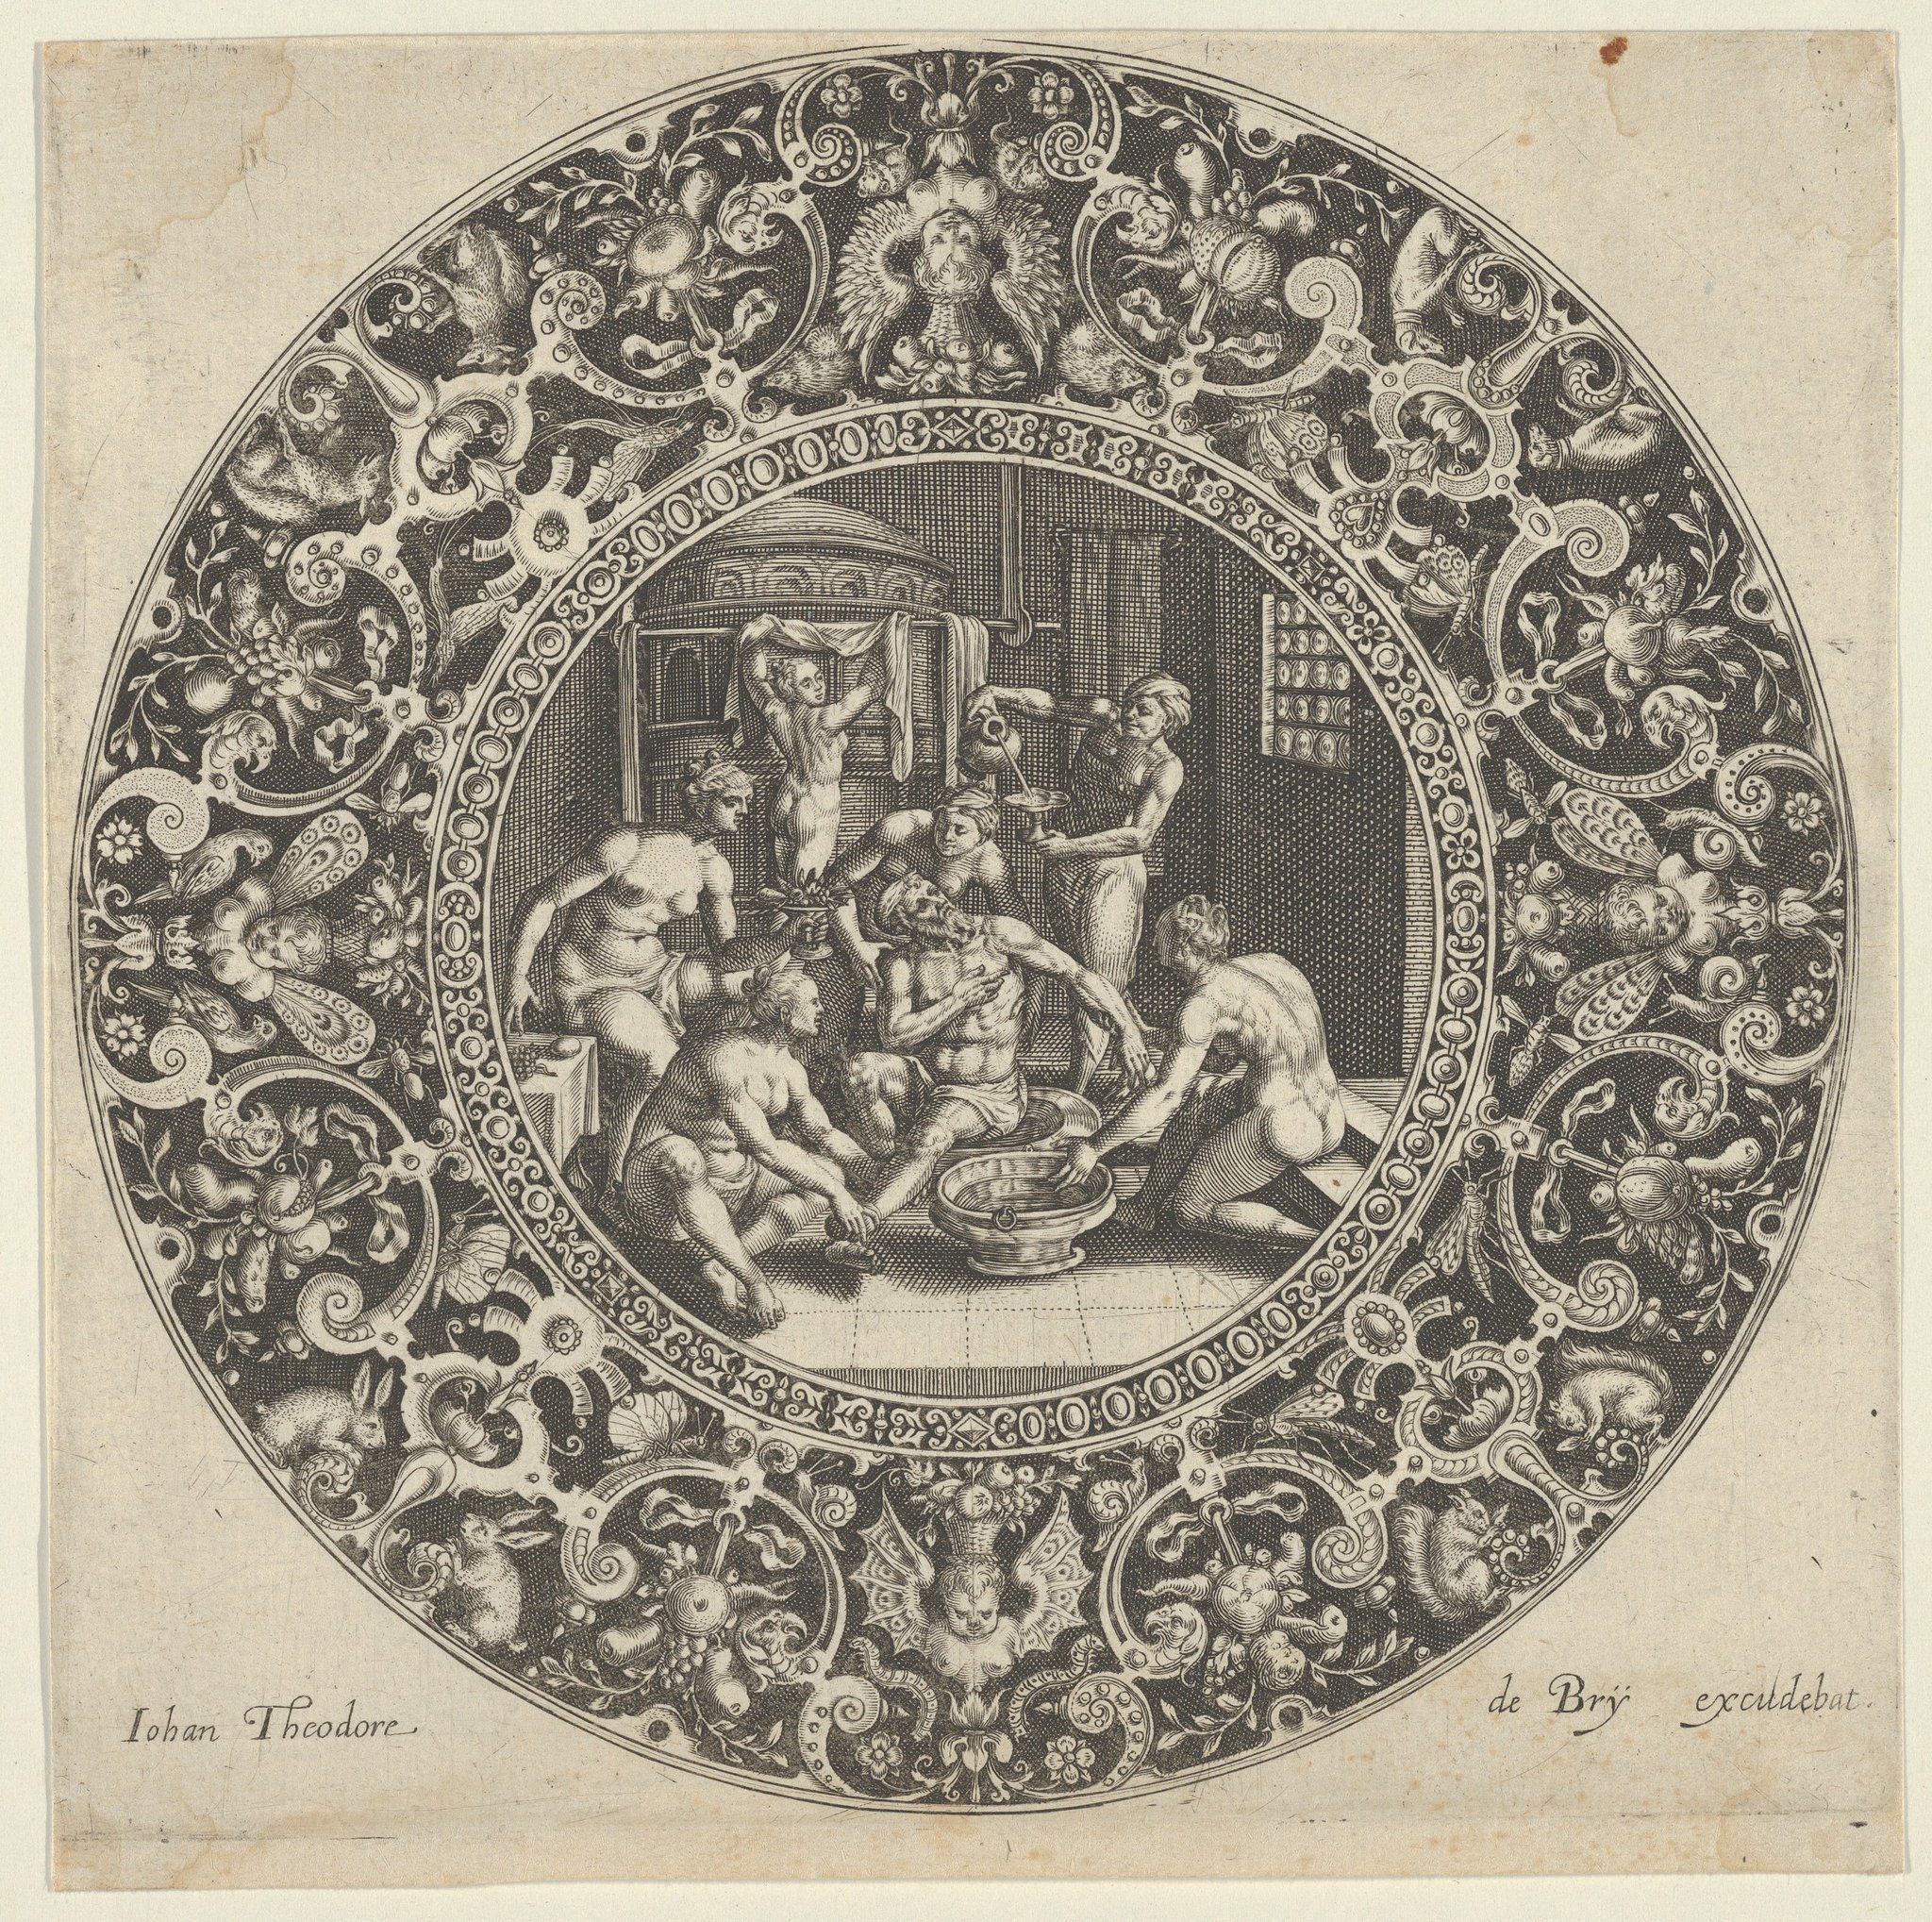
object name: print ornament architecture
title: Sardanapal in the Bath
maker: johann theodor de bry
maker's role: artist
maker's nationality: netherlandish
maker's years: 1561-1623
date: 1576-1623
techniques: engraving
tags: male nudes,female nudes,bathing